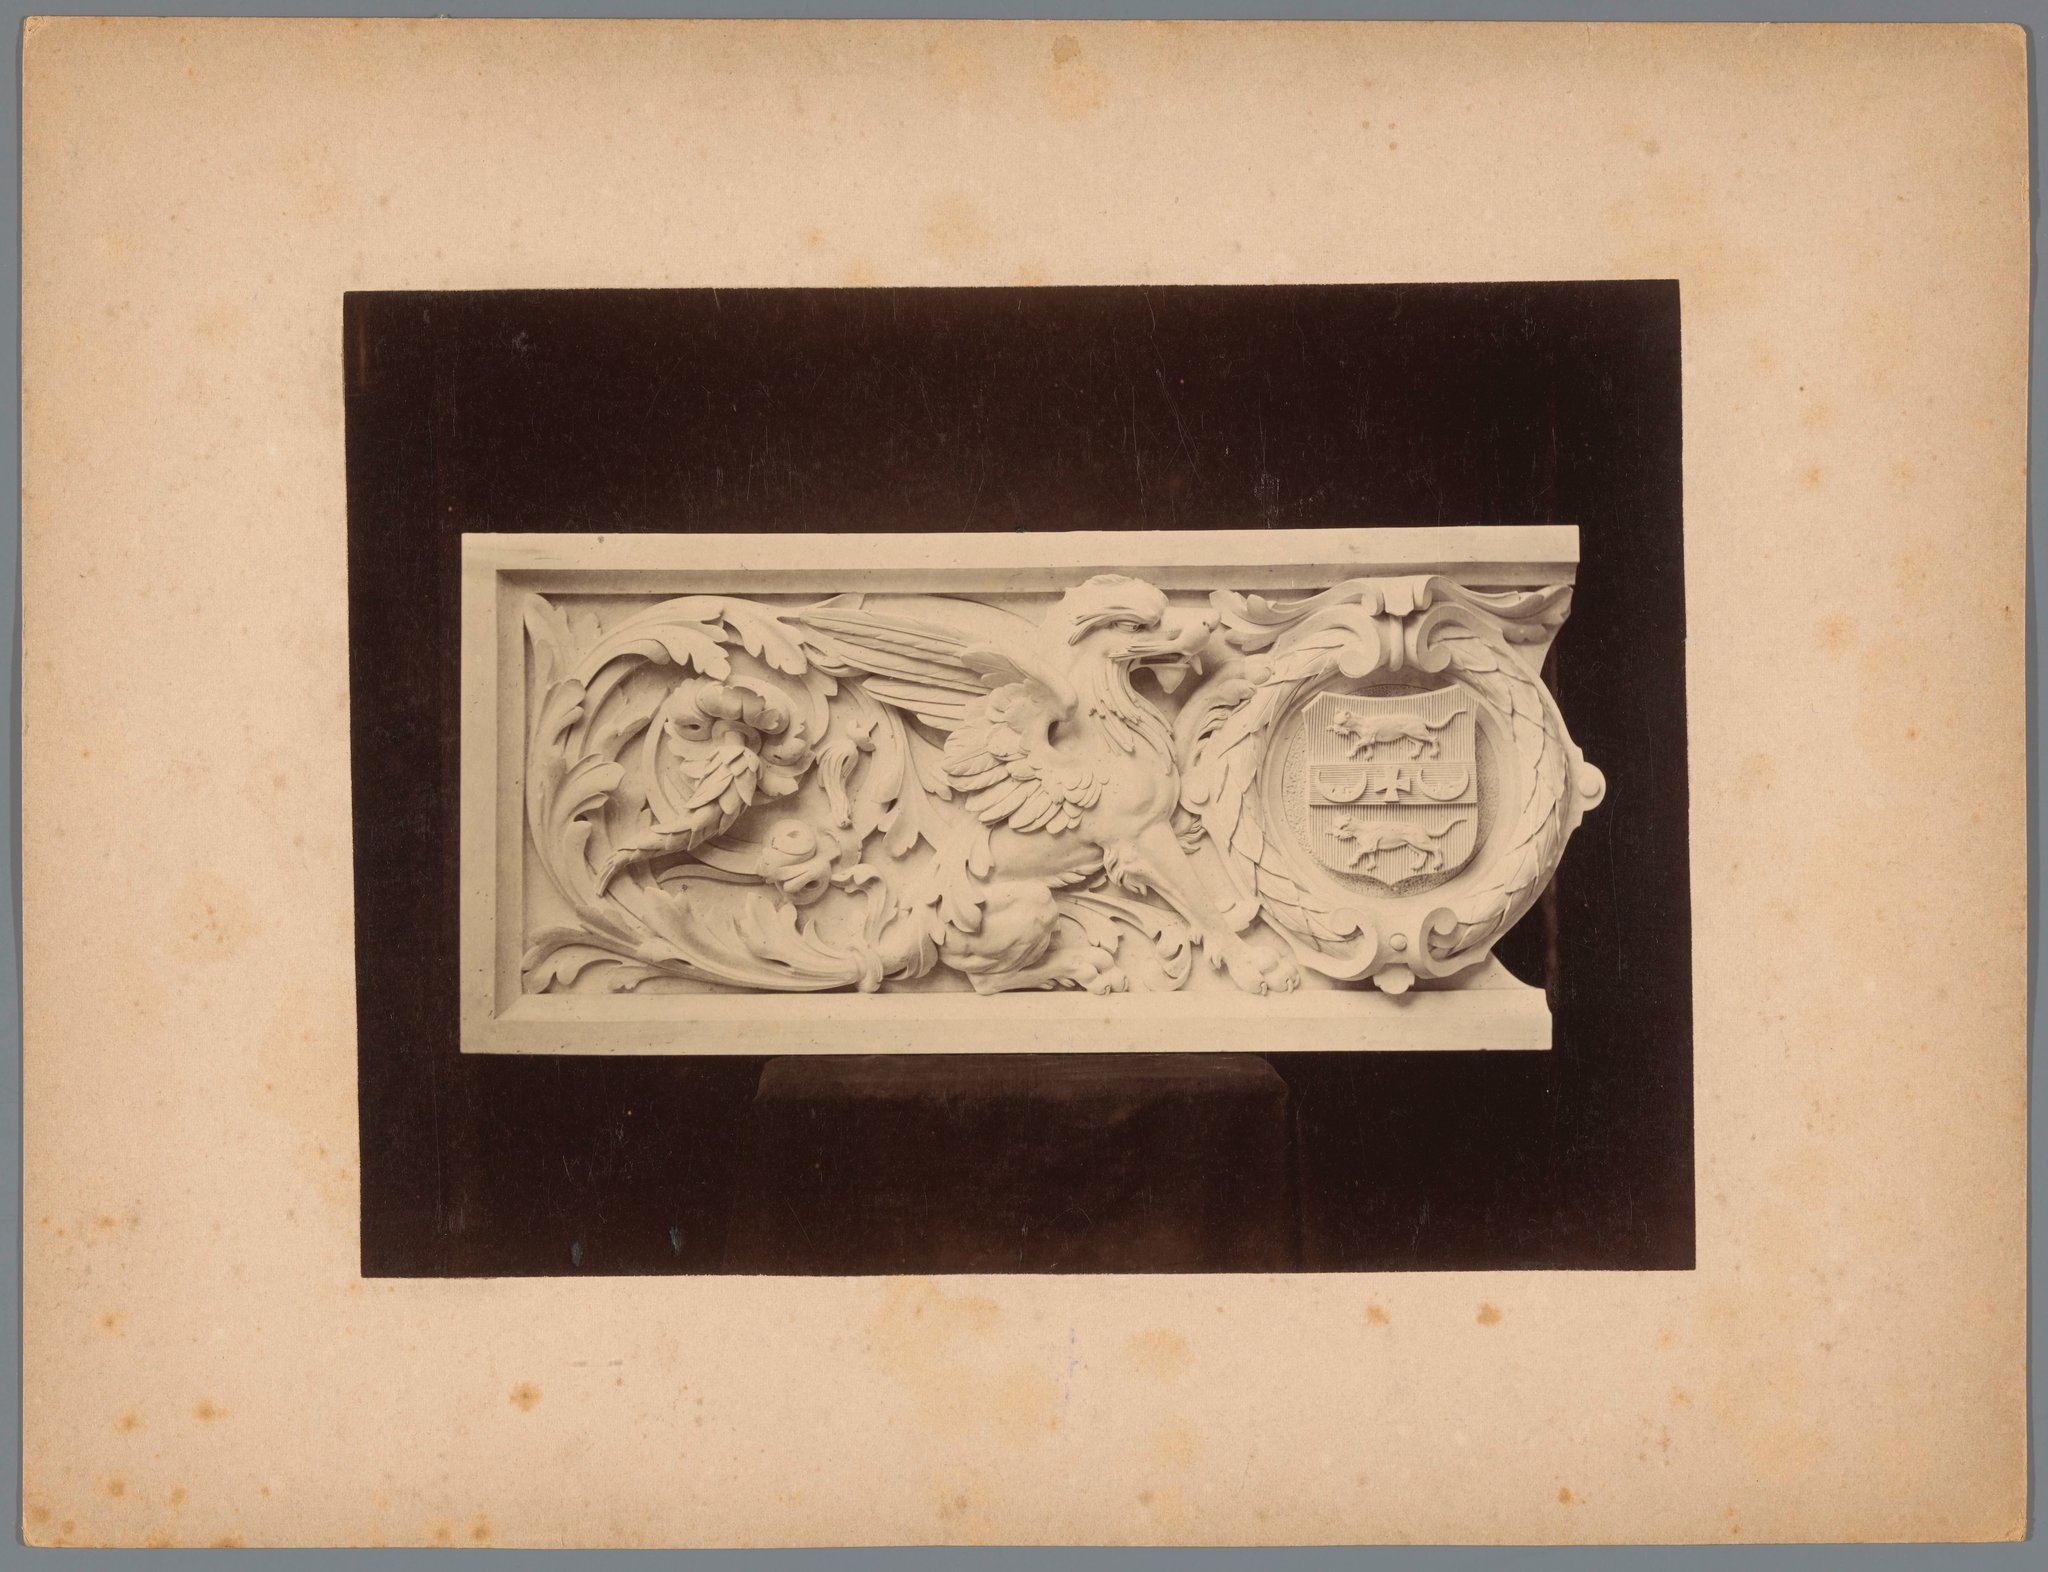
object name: photograph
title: Reliëf met een fantasiewezen en een omkranst wapenschild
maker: Anonymous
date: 1875-1900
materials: cardboard, photographic support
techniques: albumen print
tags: coat of arms (symbol of sovereignty), ornament ~ hybrid animals, ornament ~ arabesque, garland, wreath, sculpture (+ relief ~ sculpture)